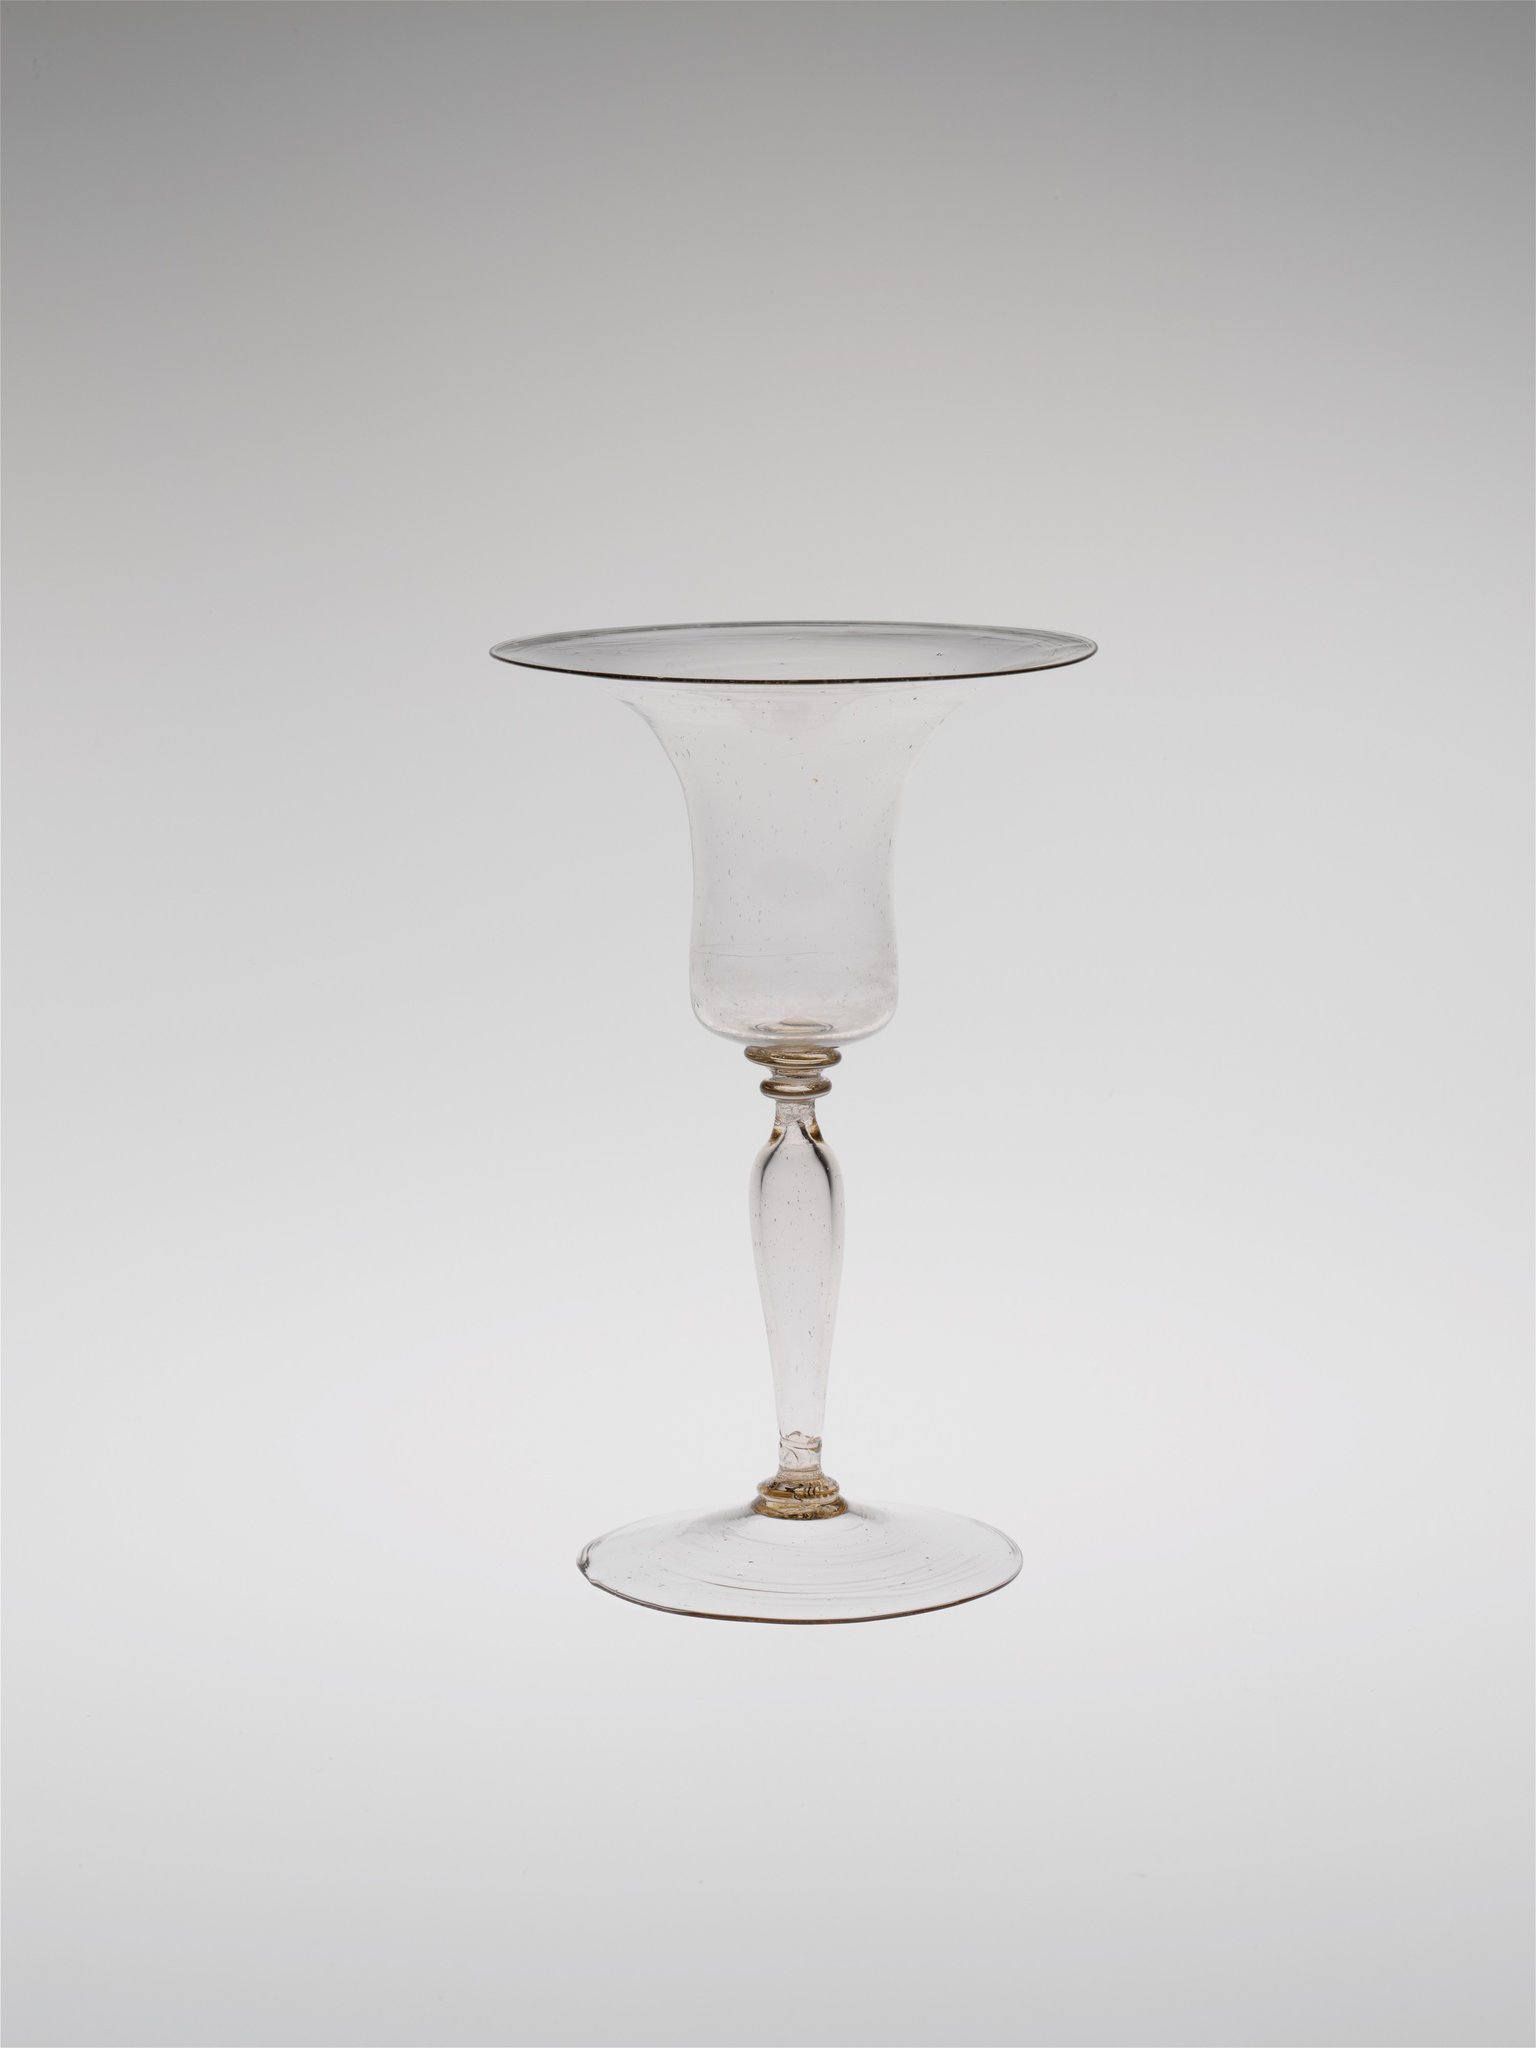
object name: wineglass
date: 1601-1700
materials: glass